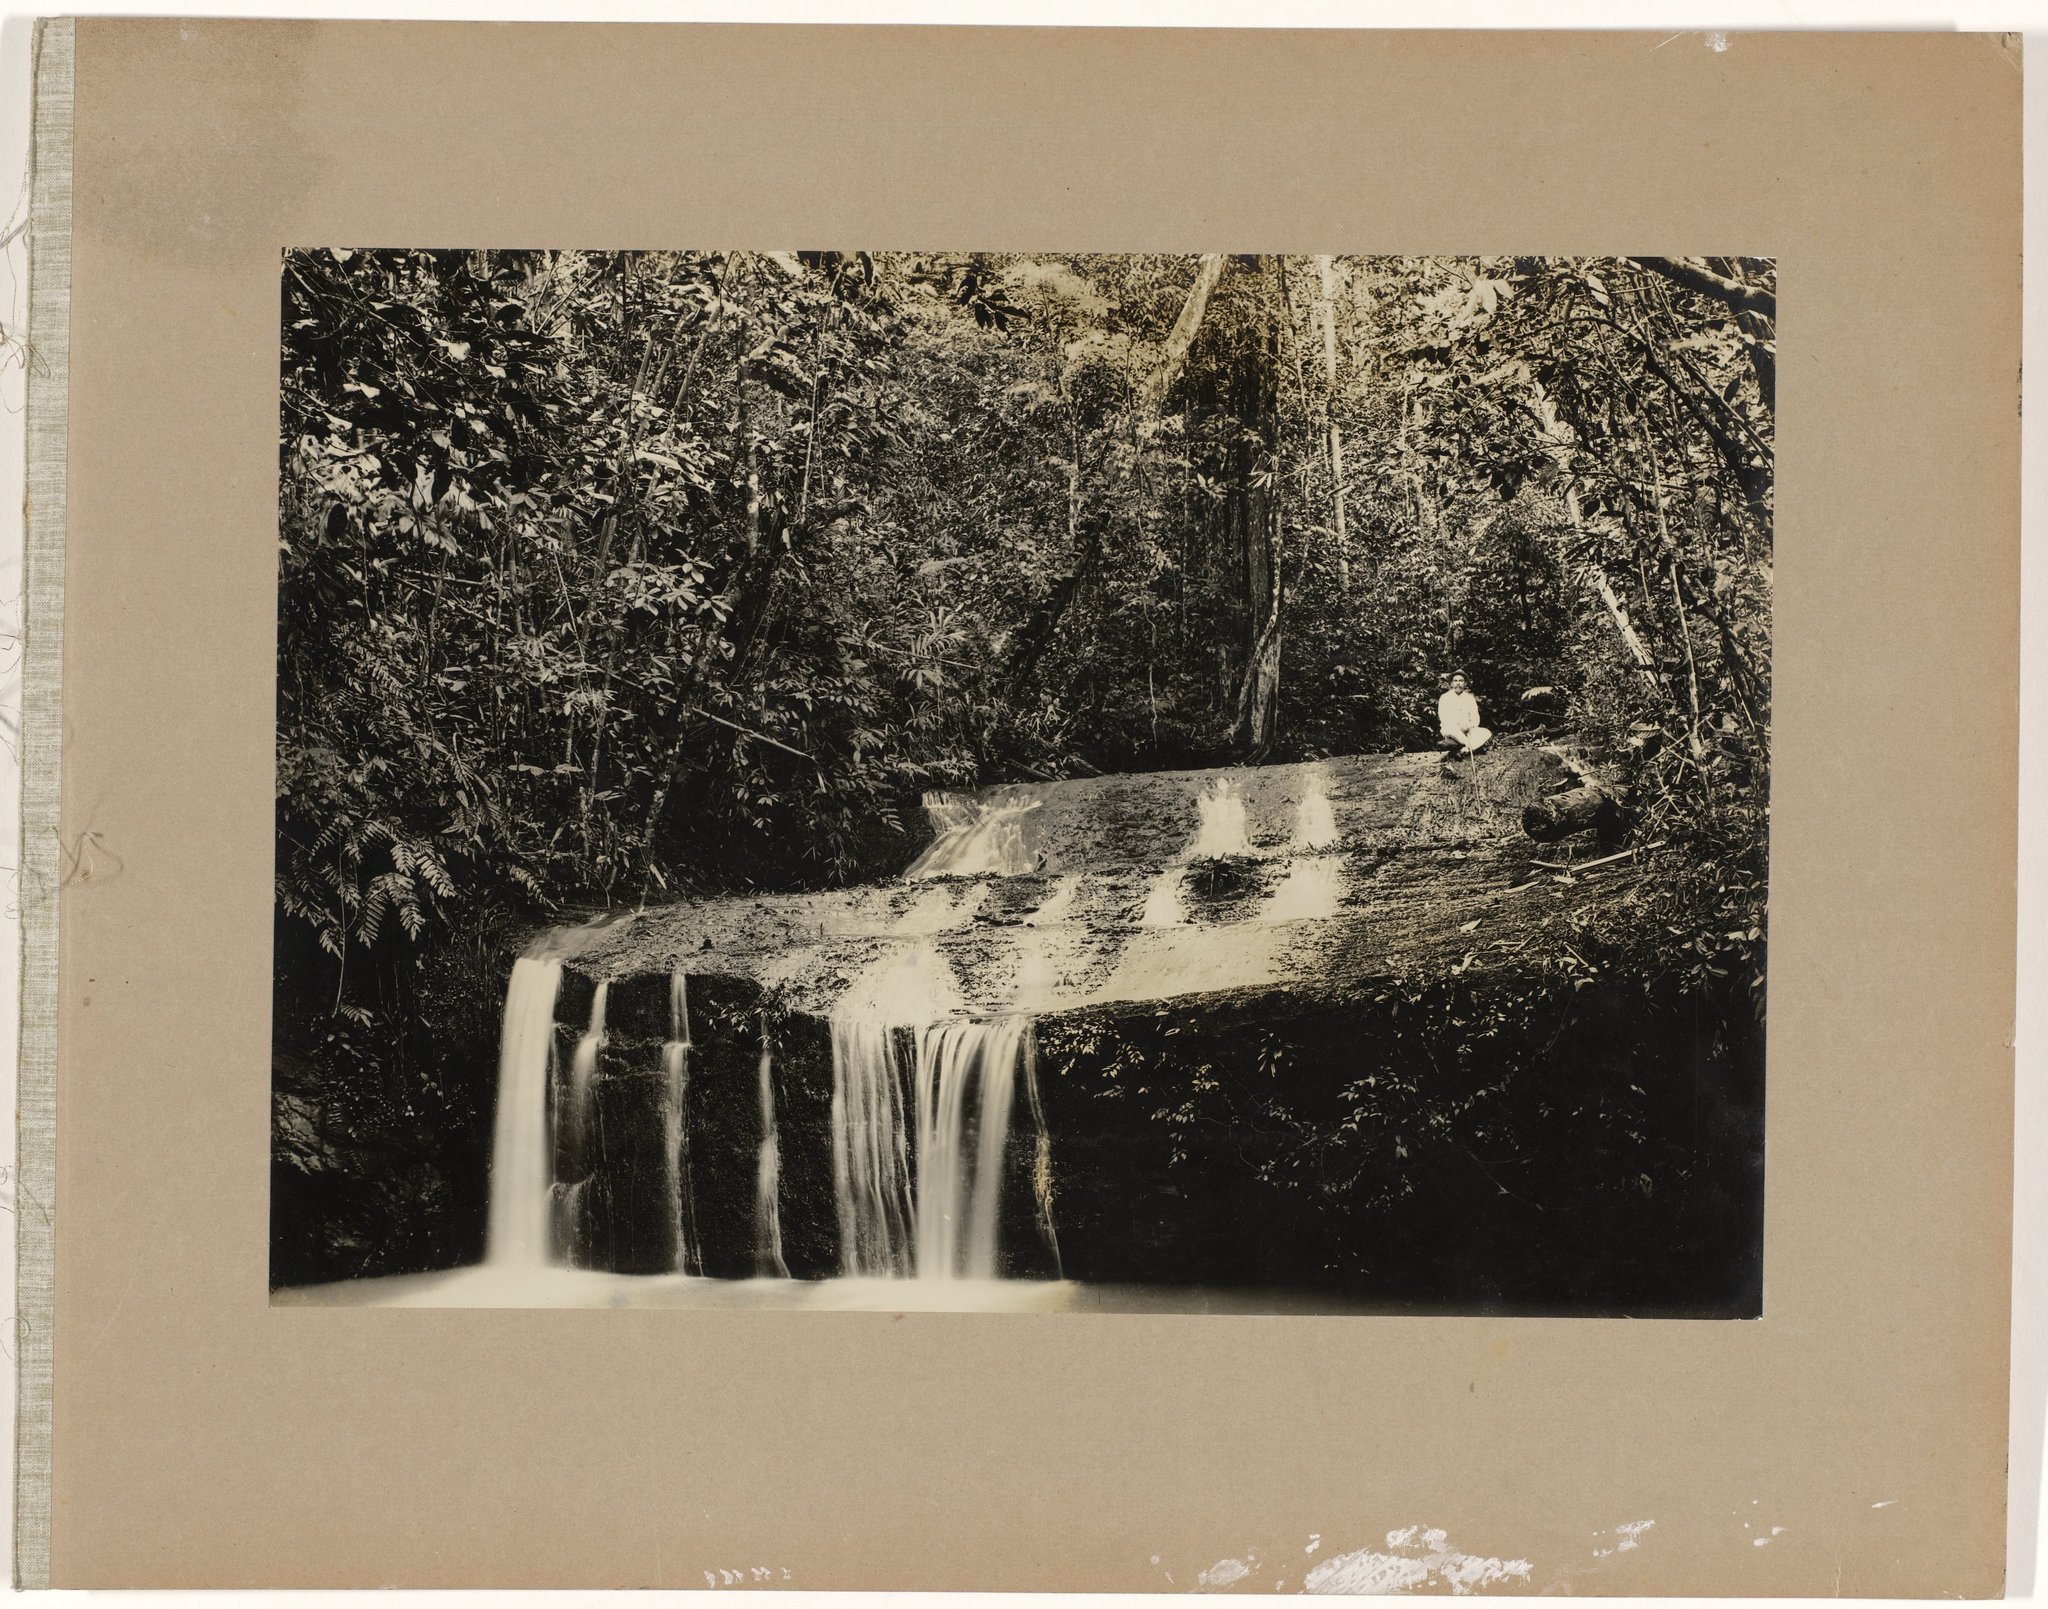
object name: photograph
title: Waterval in het woud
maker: Anonymous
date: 1921-1922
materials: photographic support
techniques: gelatin silver print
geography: bukit asam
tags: colonial system, waterfall, sumatra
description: Een waterval in het woud, bovenaan zit een man op de stenen. Onderdeel van het losbladige fotoalbum aangeboden door het personeel van de Boekit-Asam Steenkolenmijnen op Sumatra aan de scheidende Ingenieur-Directeur H. Tromp op 7 januari 1922.